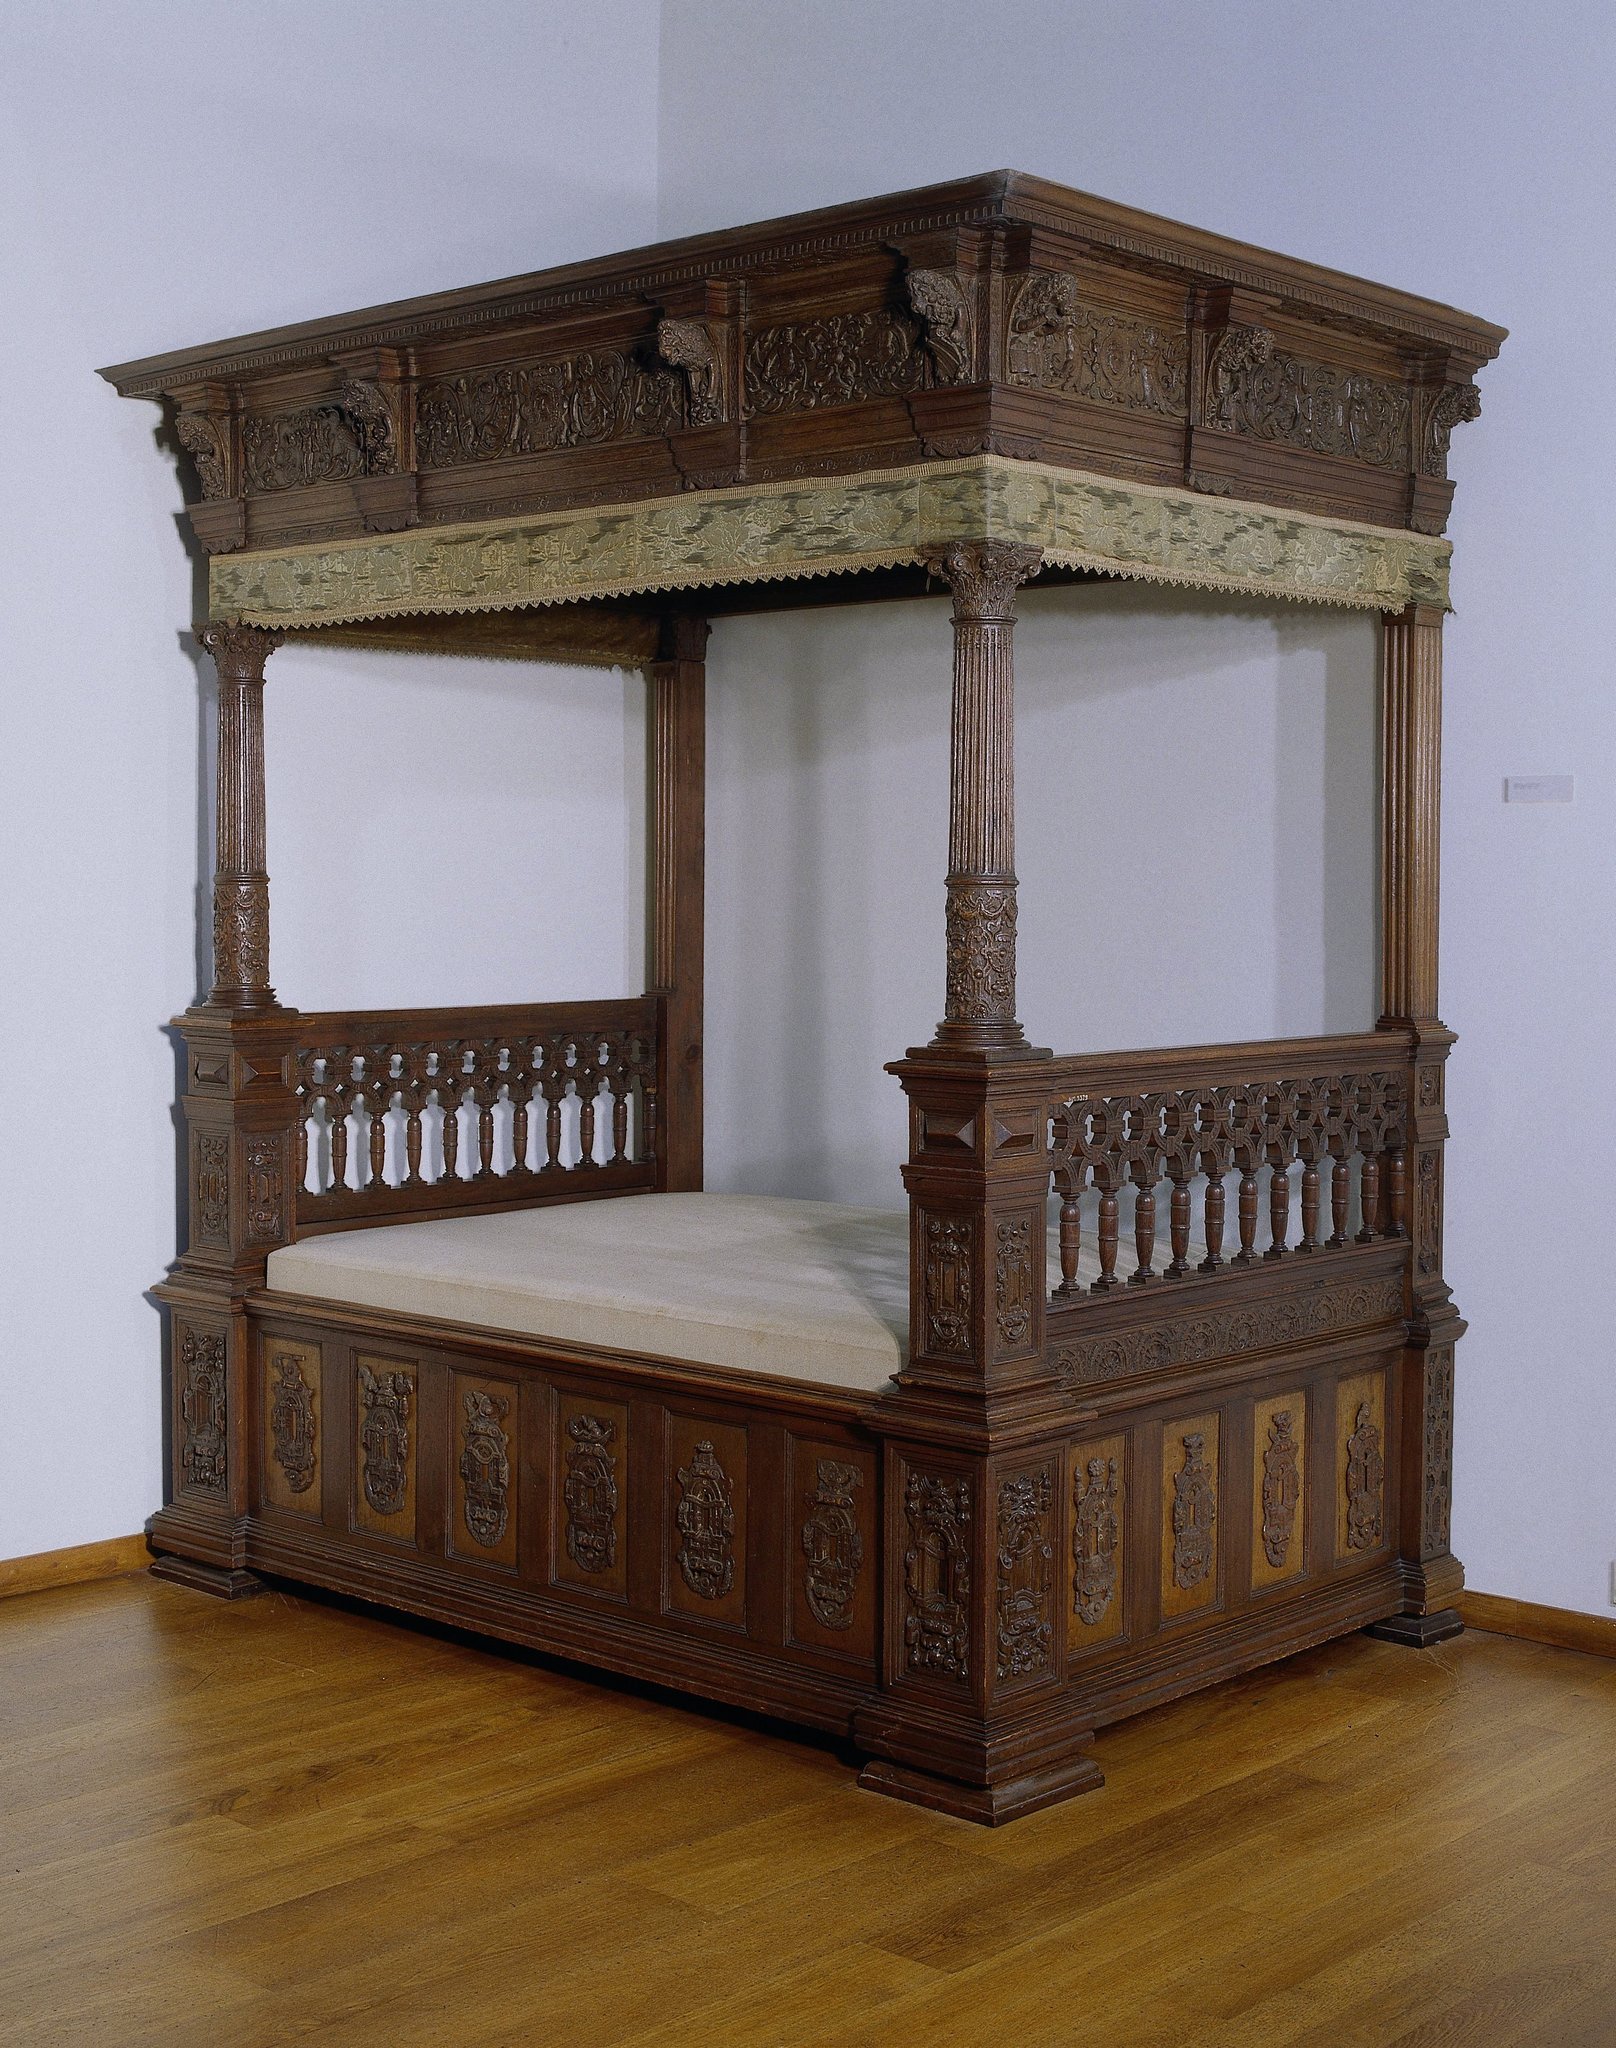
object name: furniture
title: Ledikant van eikenhout, met hoekstijlen en versieringen op fries en panelen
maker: Anonymous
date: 1600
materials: wood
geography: northern netherlands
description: Bedstead. Oak. Netherlands, c. 1600, recontructed in the 19th century.